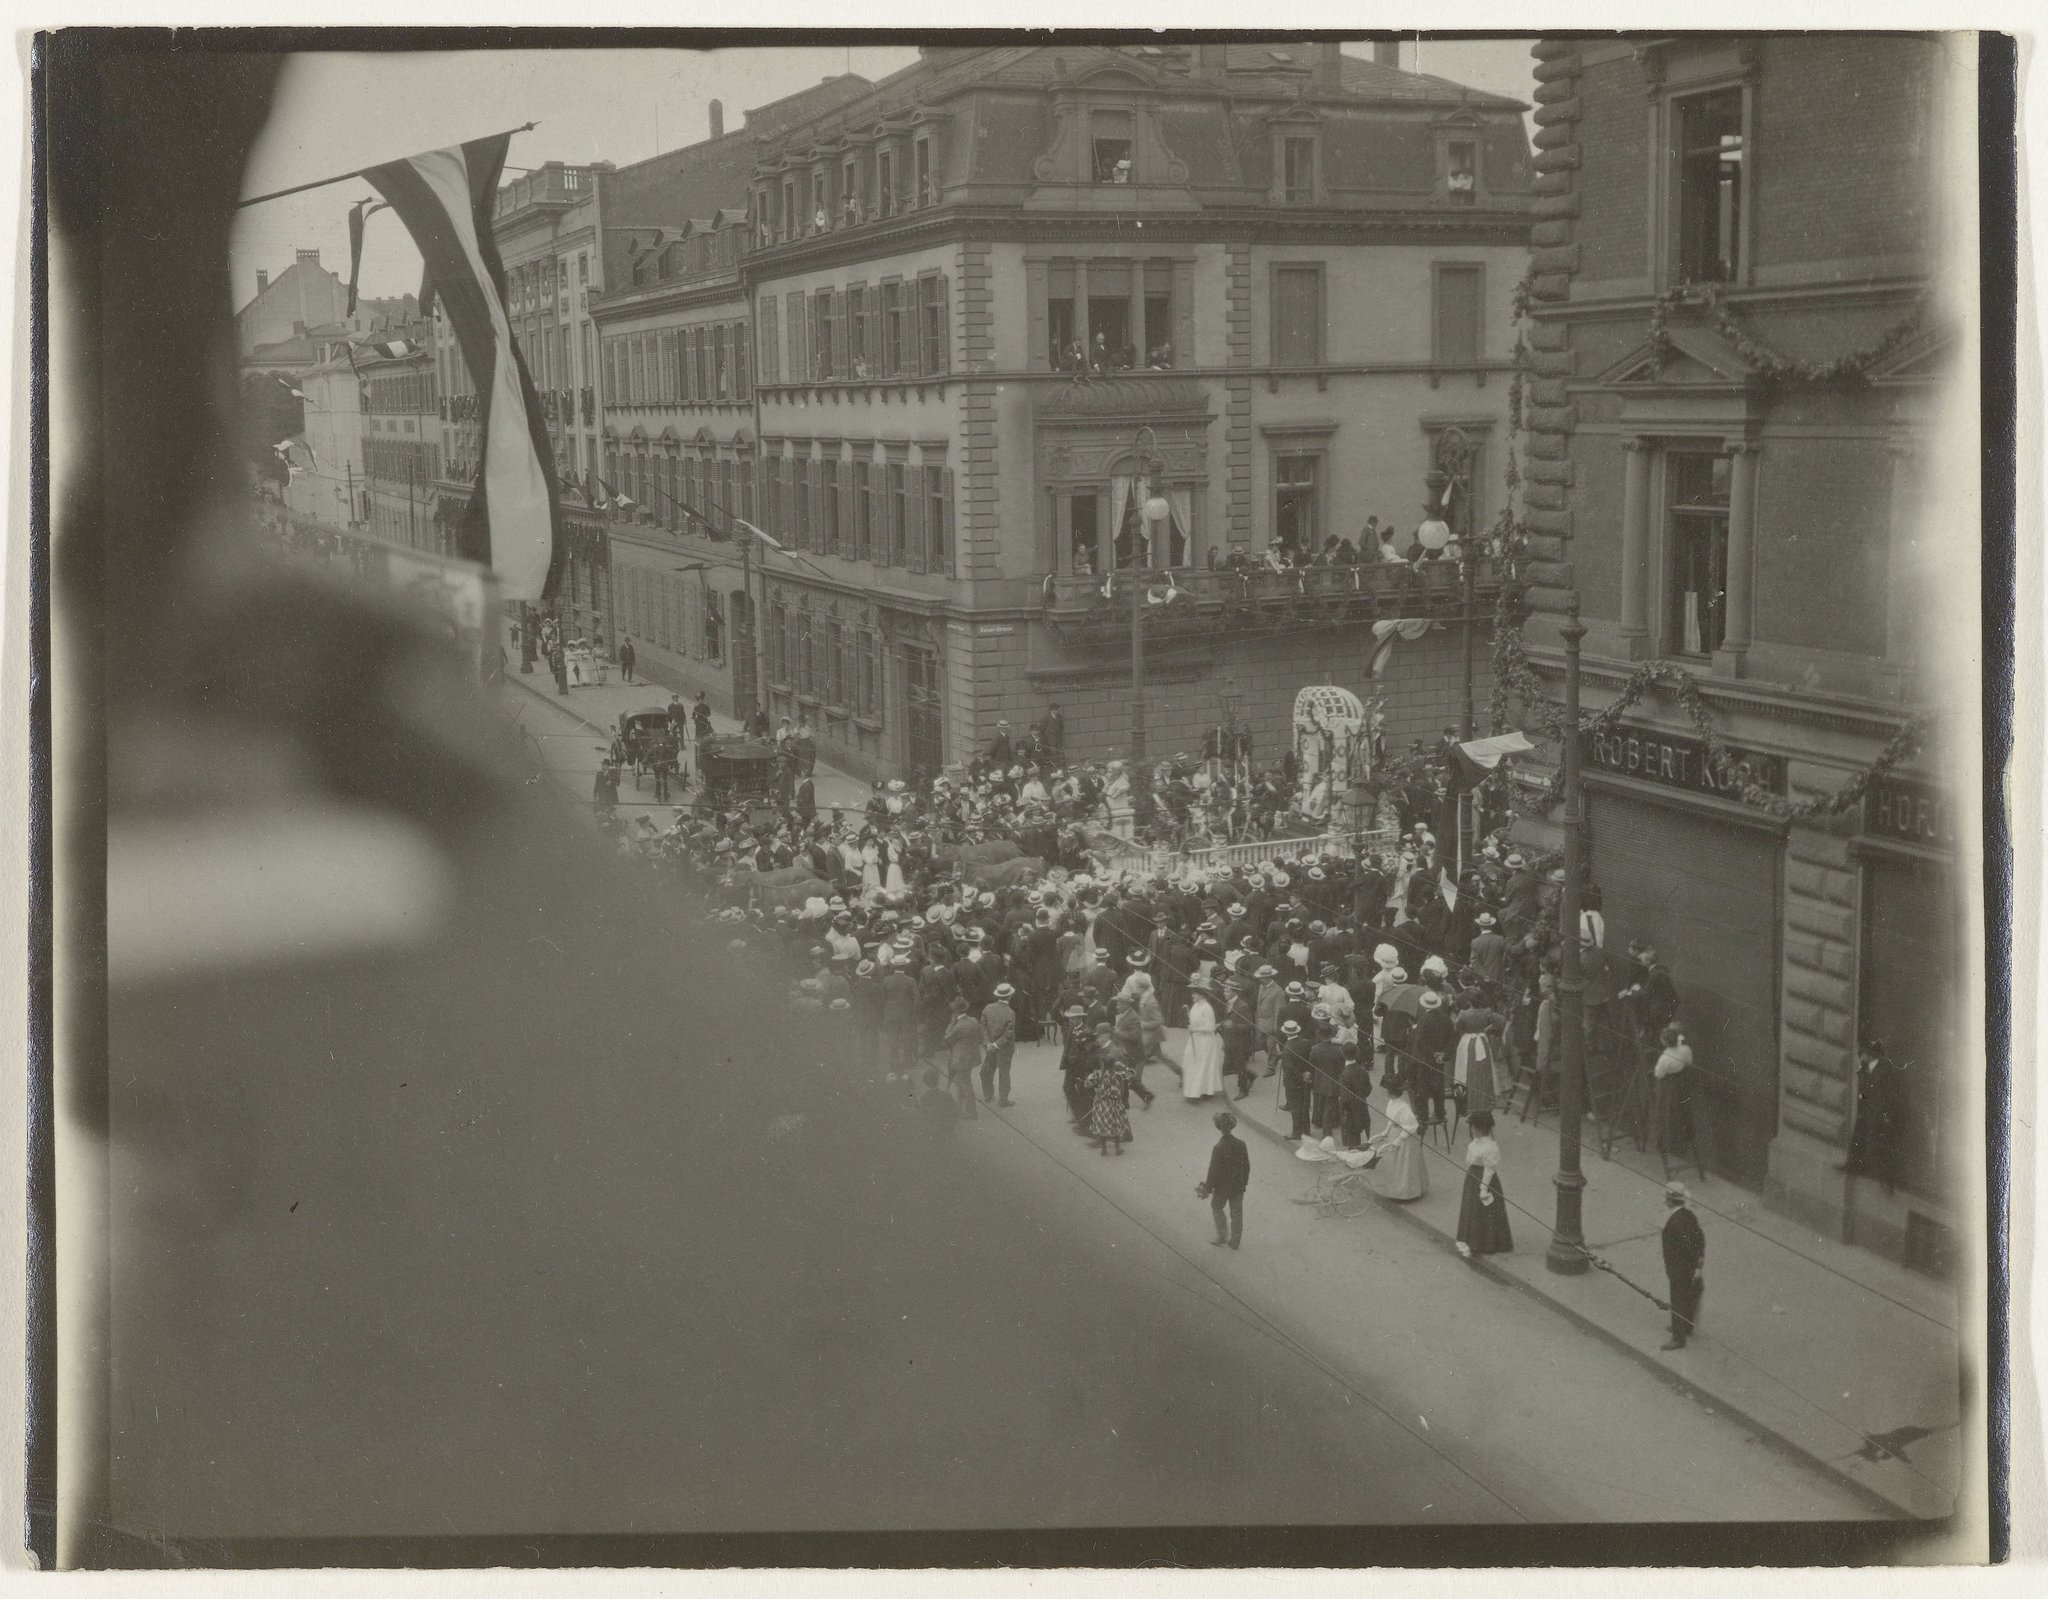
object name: photograph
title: Gezicht in een stad, mogelijk Brussel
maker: Anonymous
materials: paper, photographic support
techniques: gelatin silver print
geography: frankfurt am main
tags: street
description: Gezicht op de kruising van de Mainzestrasse met de Kaiserstrasse in Frankfurt am Main. Rechts de winkel van hofjuwelier Robert Koch. De mensen op straat lijken te kijken naar een optocht.